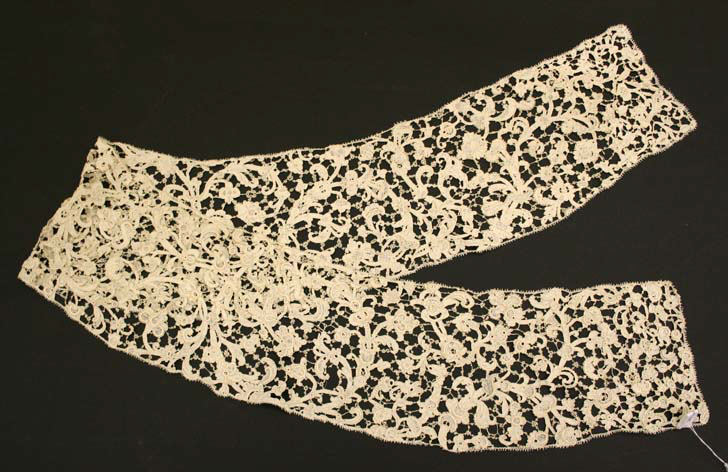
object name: collar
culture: italian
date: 1601-1700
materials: linen